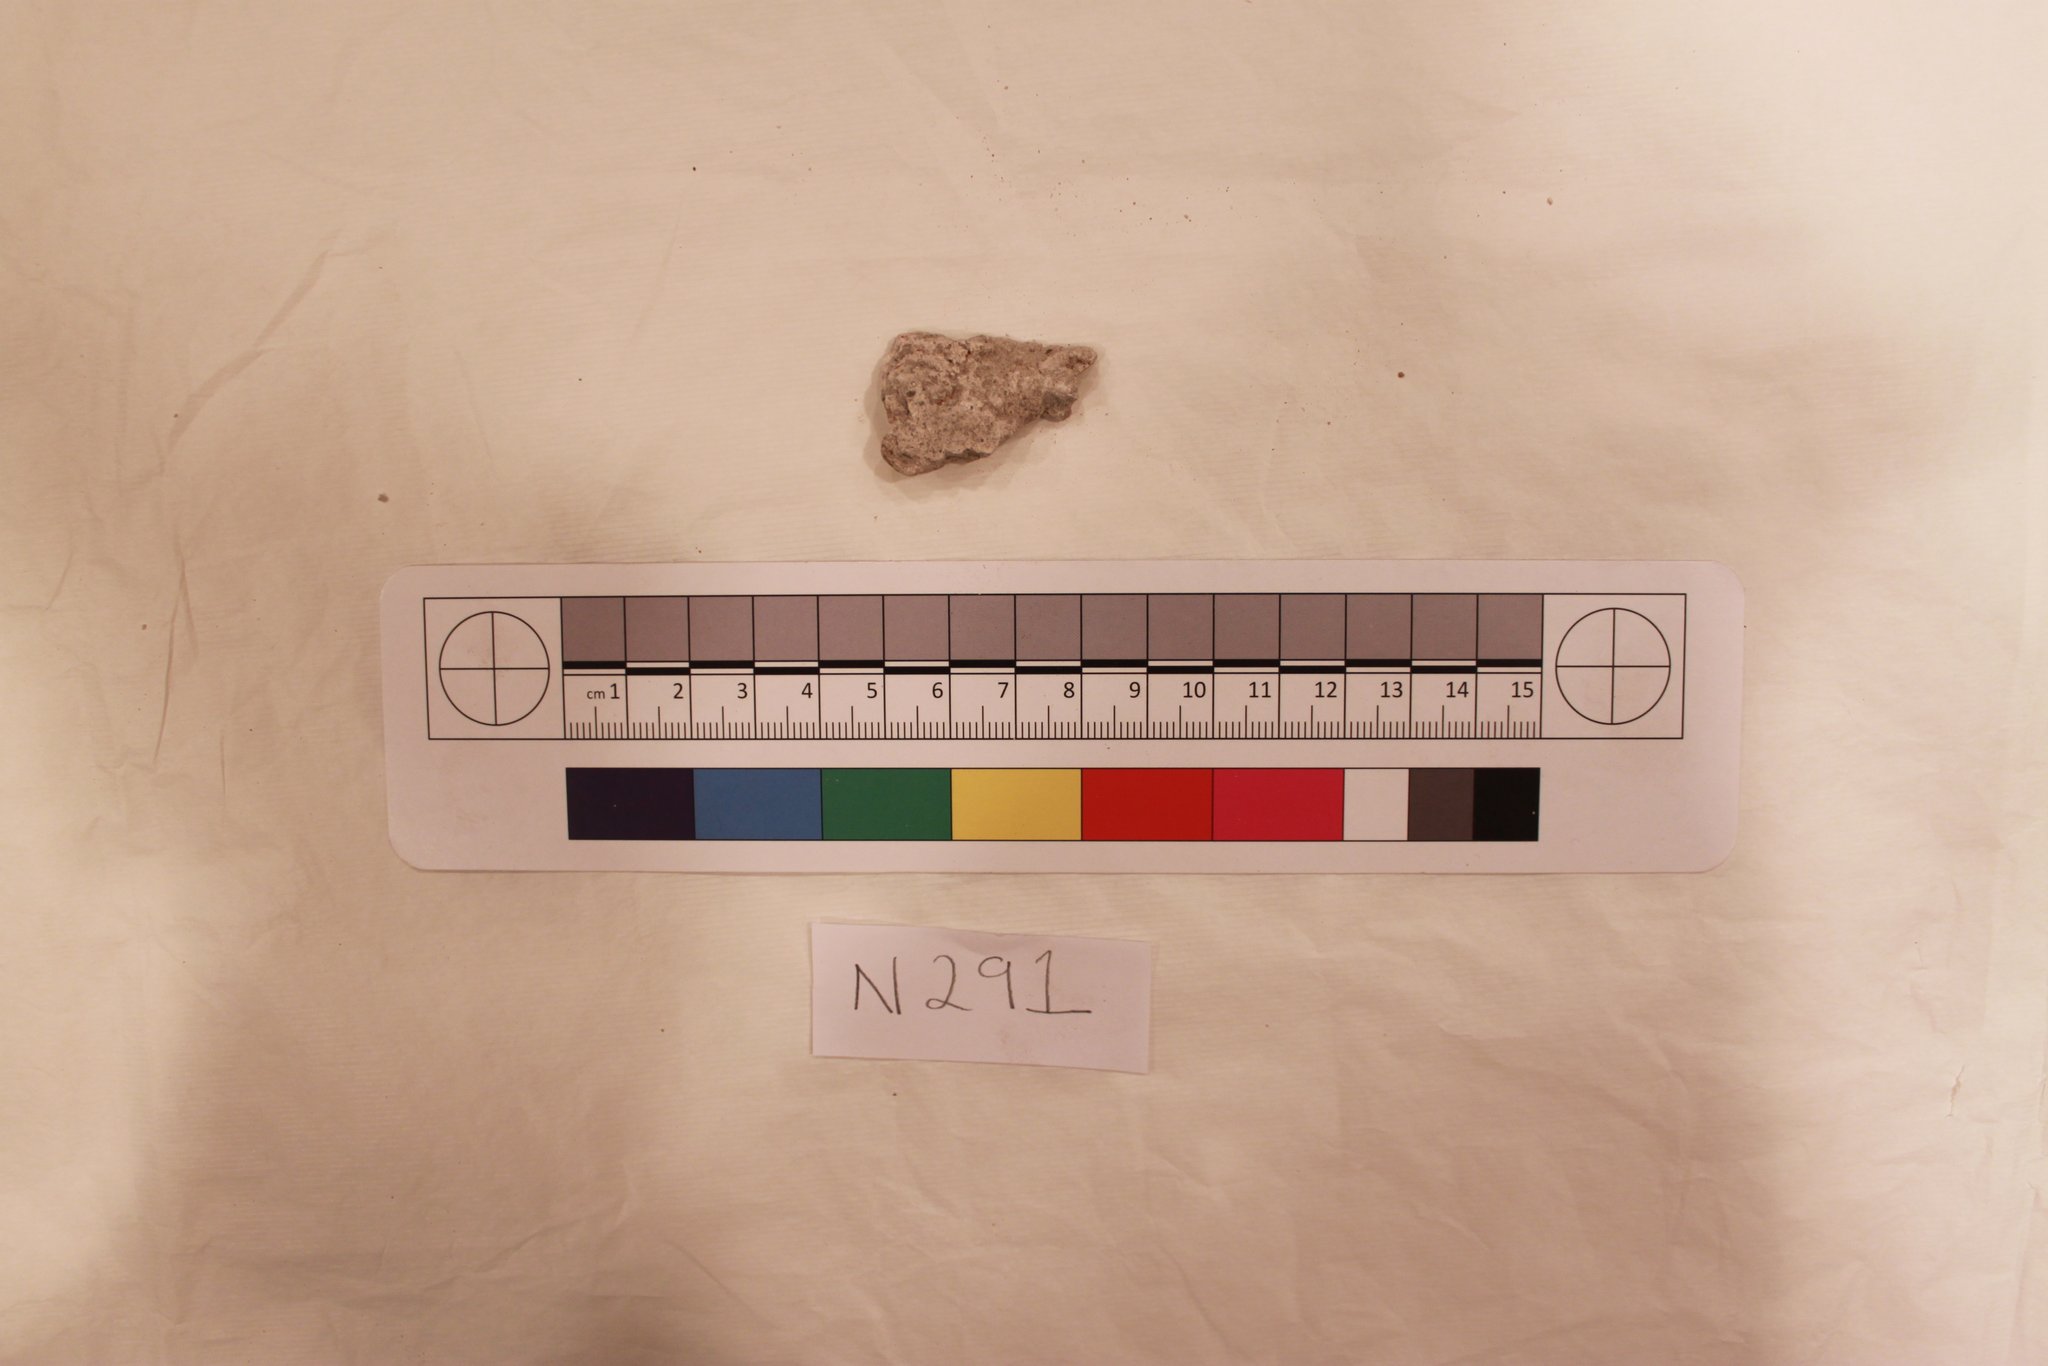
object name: fragment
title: Stucco Fragment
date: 701-1200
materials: plaster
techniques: carving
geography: iran